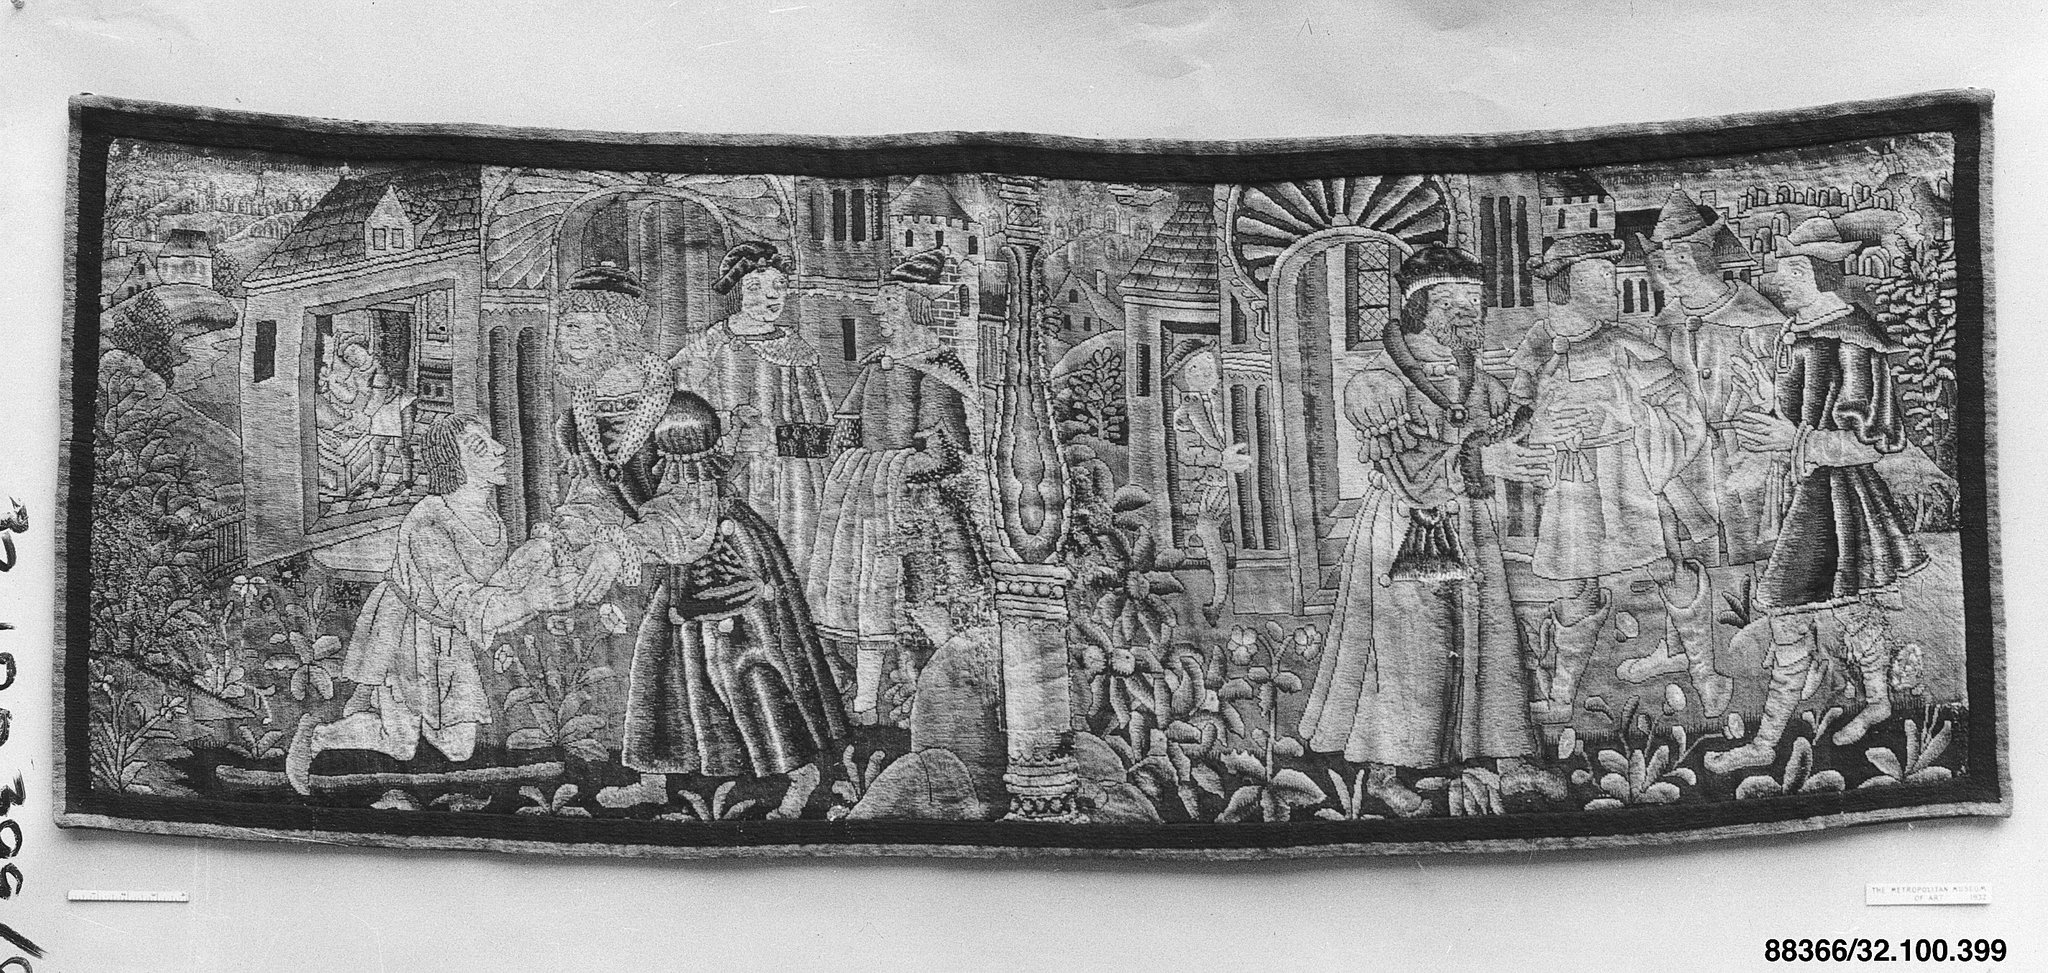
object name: valance fragment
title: Part of a valance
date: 1567-1600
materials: canvas, wool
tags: houses,men,flowers